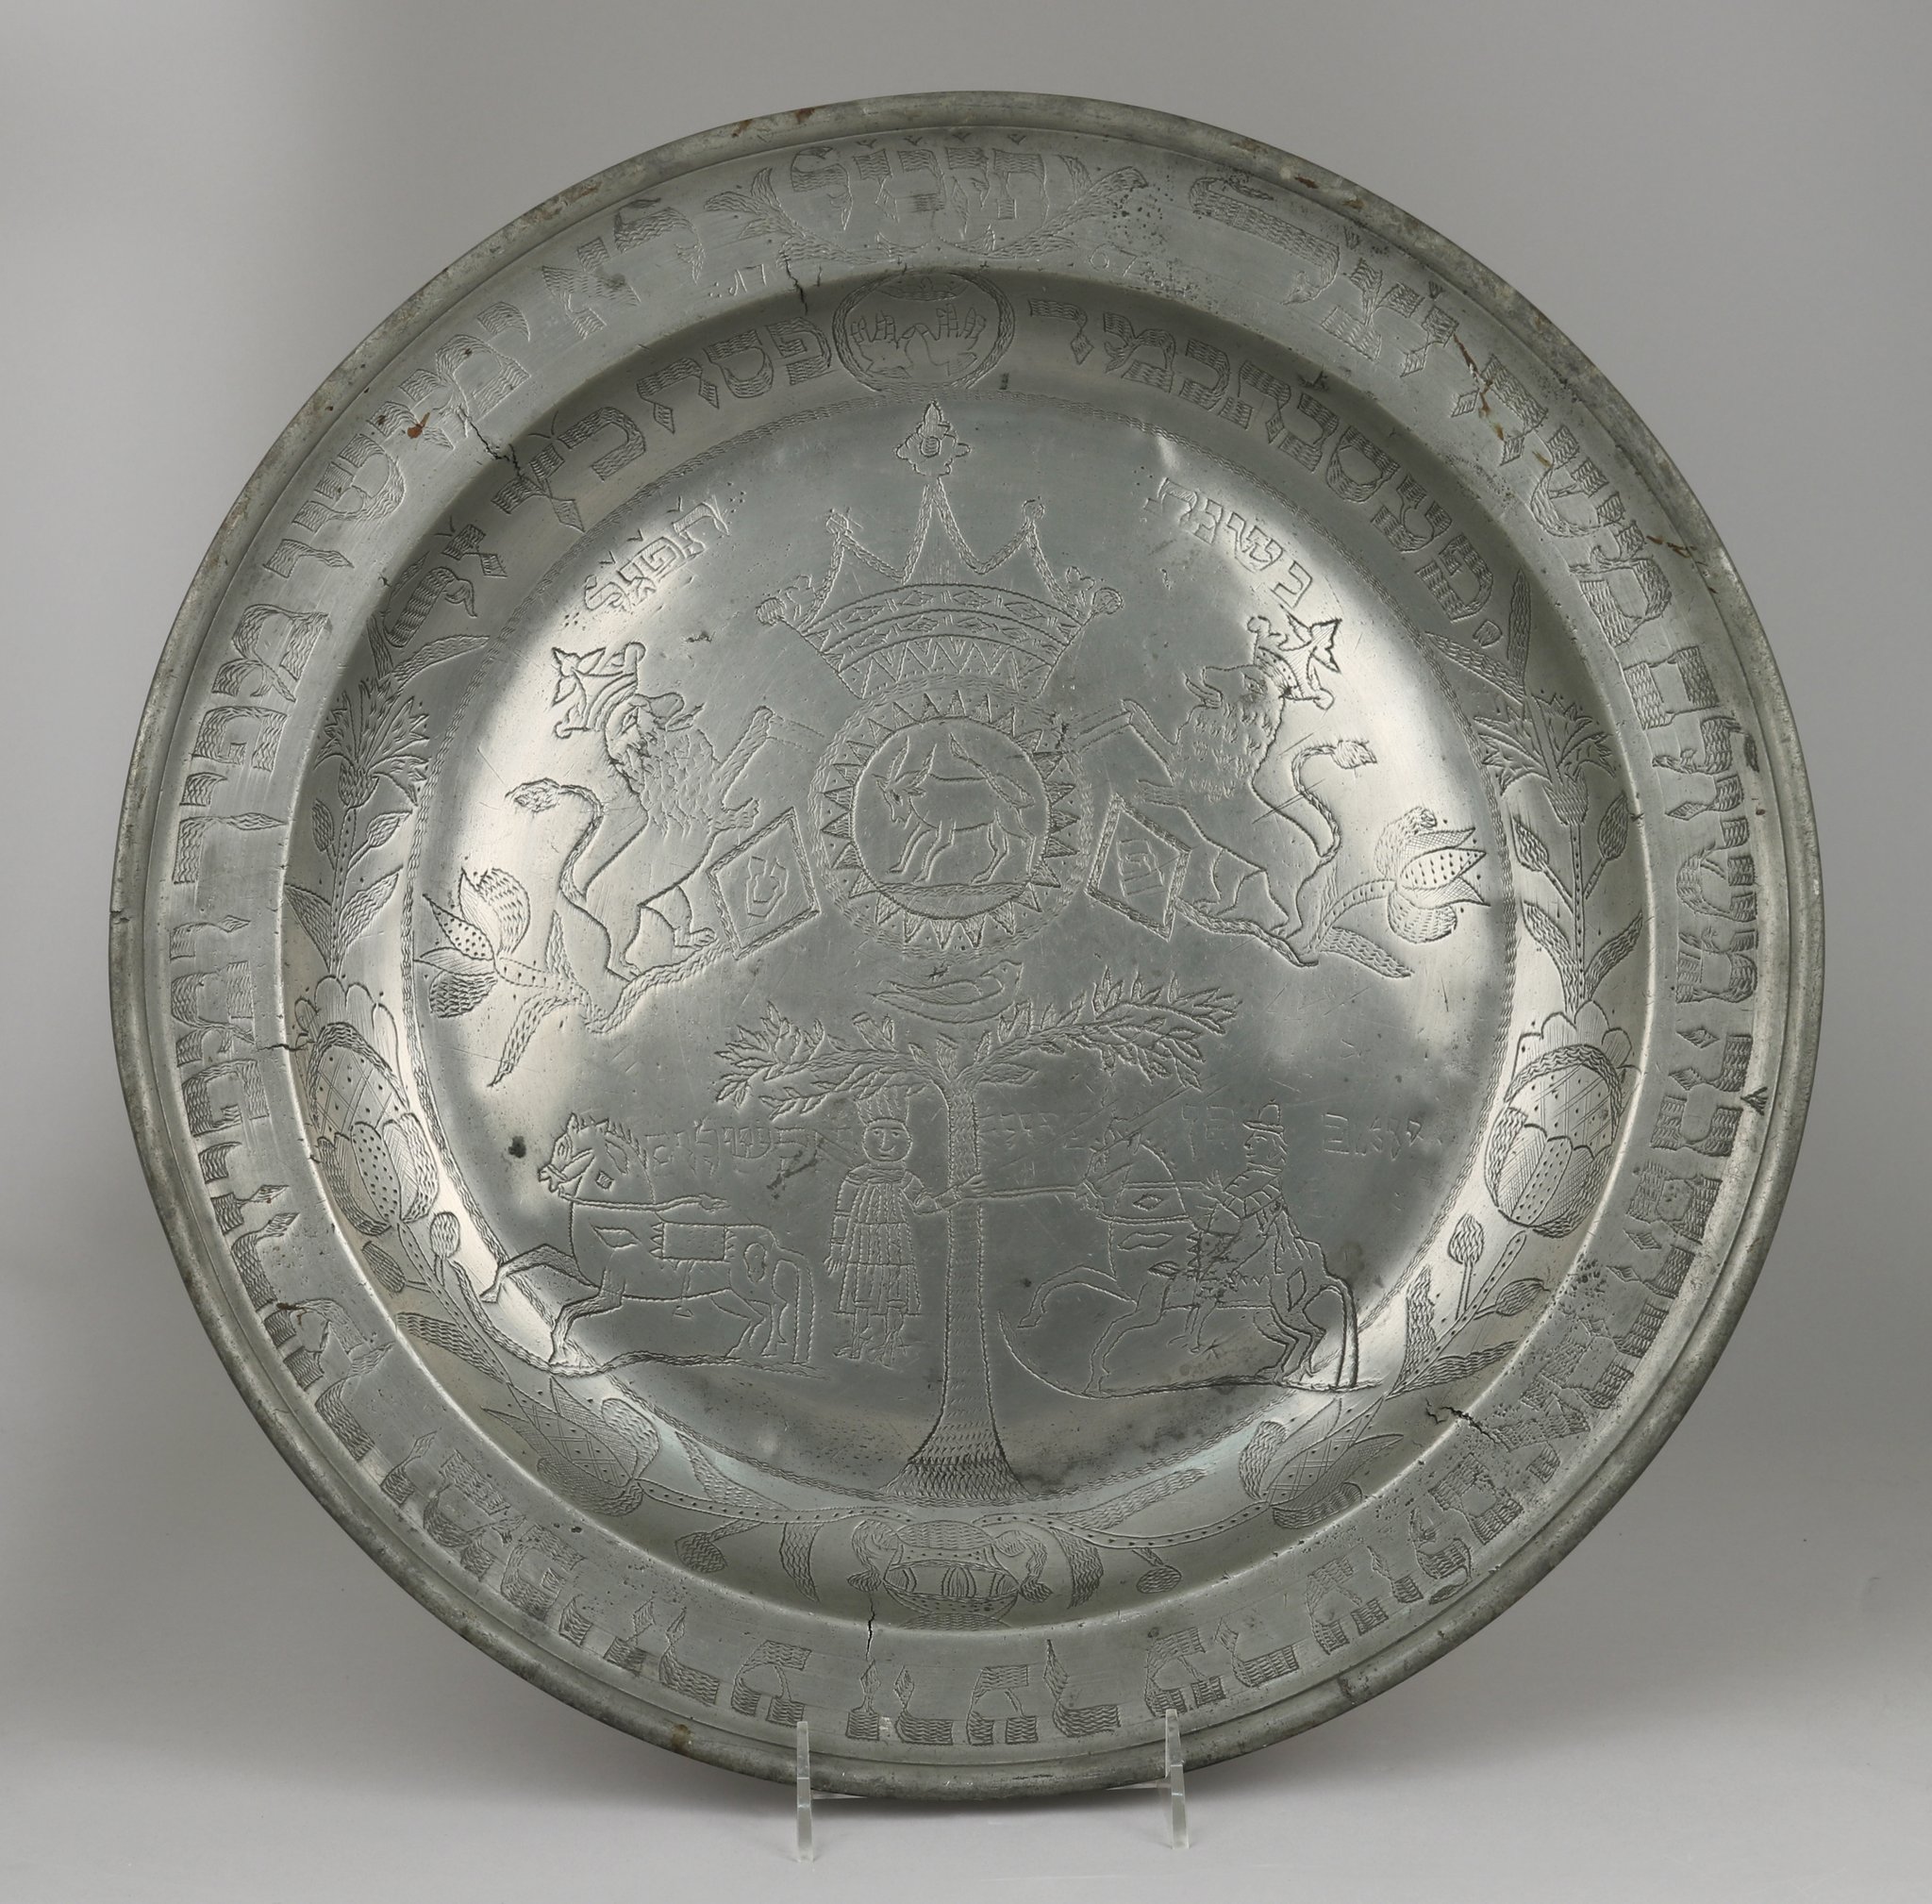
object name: plate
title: Redemption of the First-Born Ceremony plate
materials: pewter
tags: horses,lions,trees,coat of arms